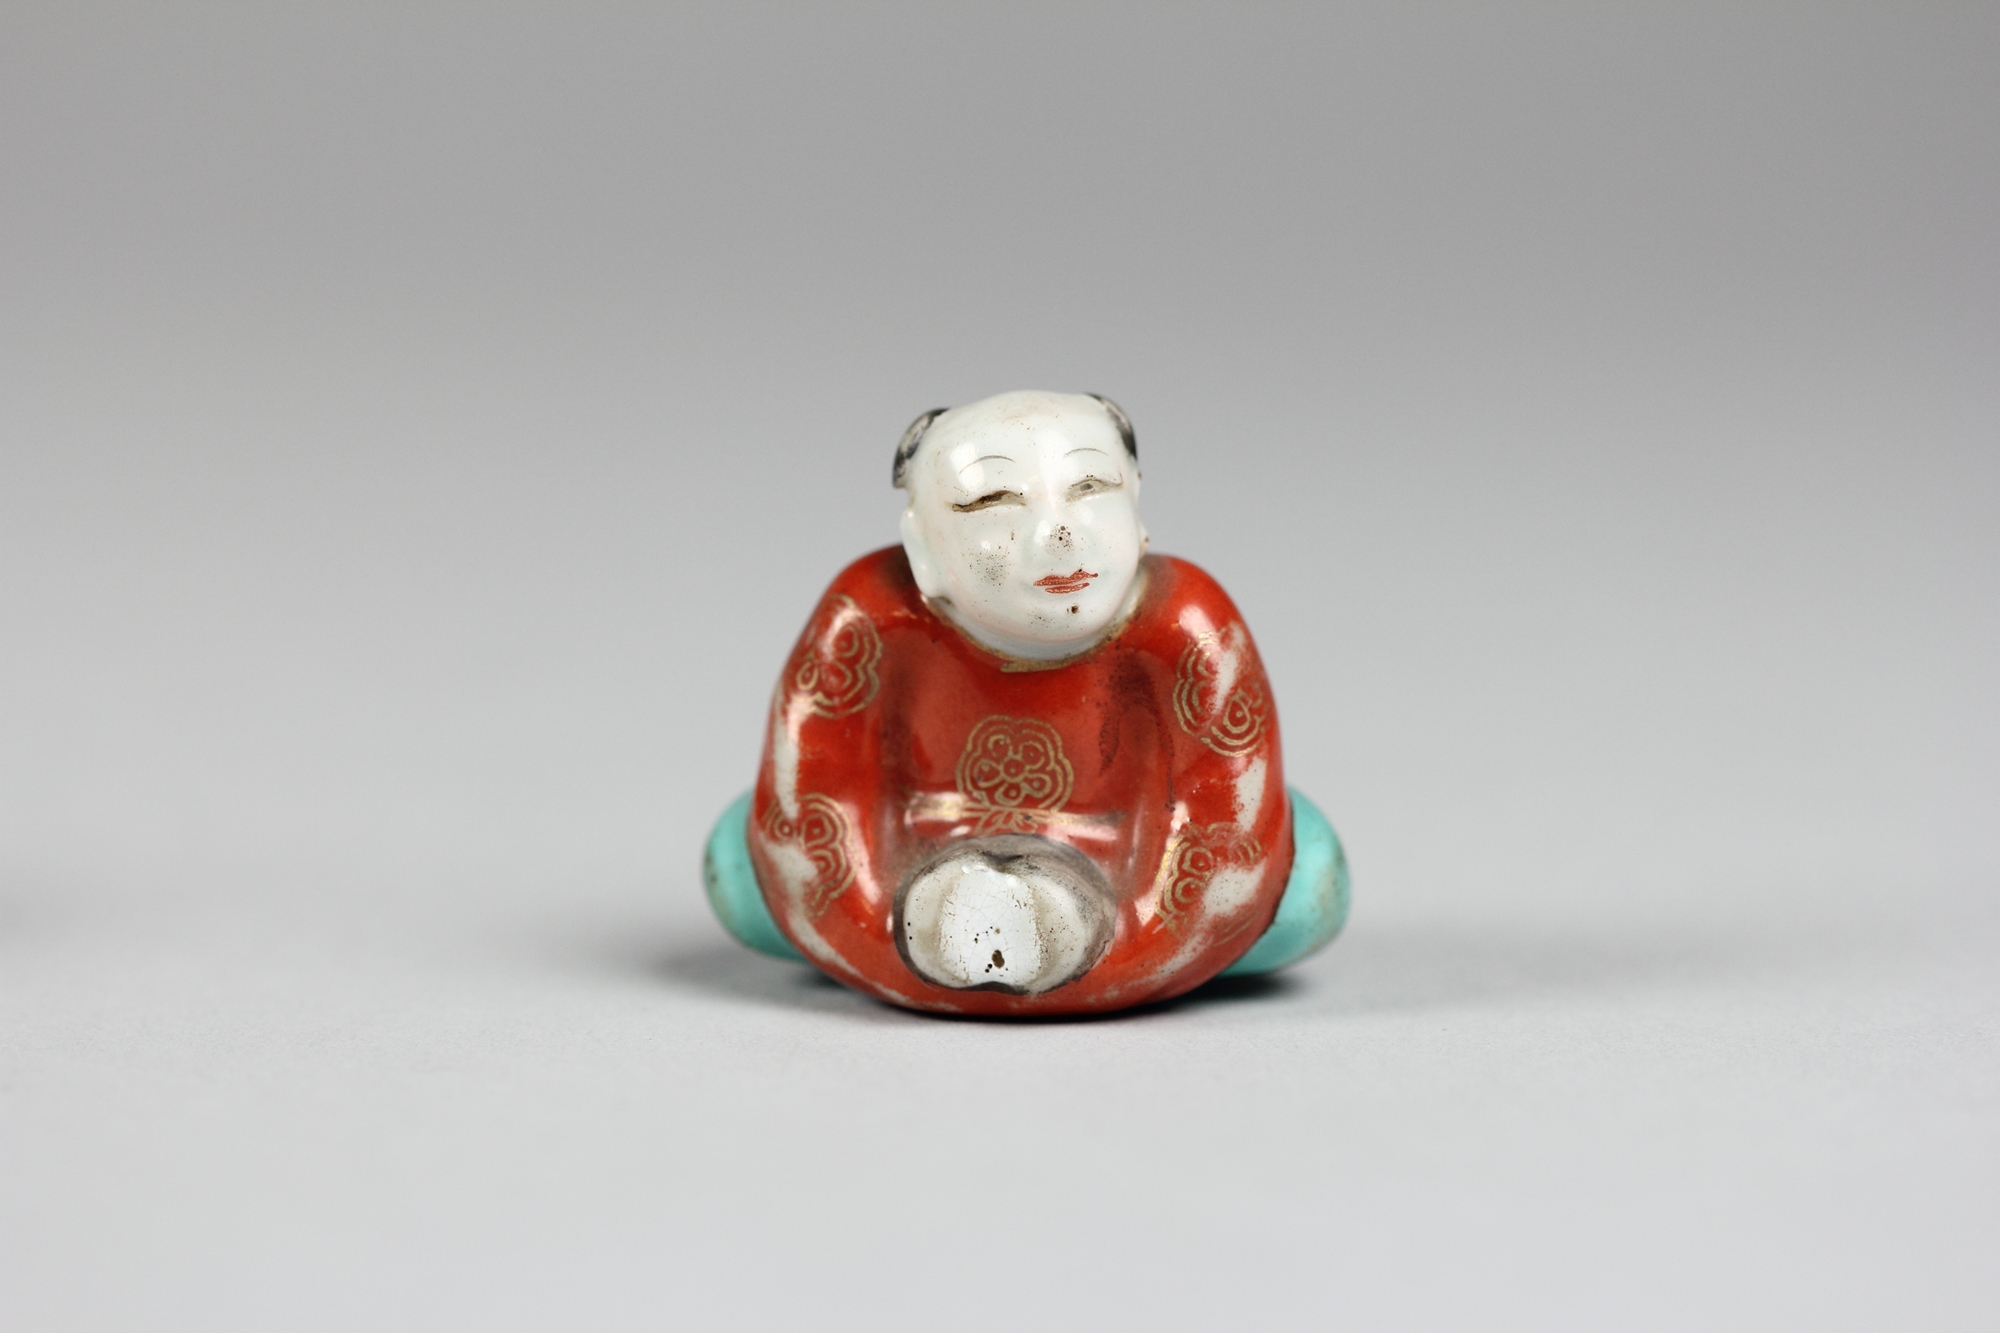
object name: netsuke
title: Netsuke of Boy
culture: japanese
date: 1801-1900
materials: enamel, porcelain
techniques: painting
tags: boys